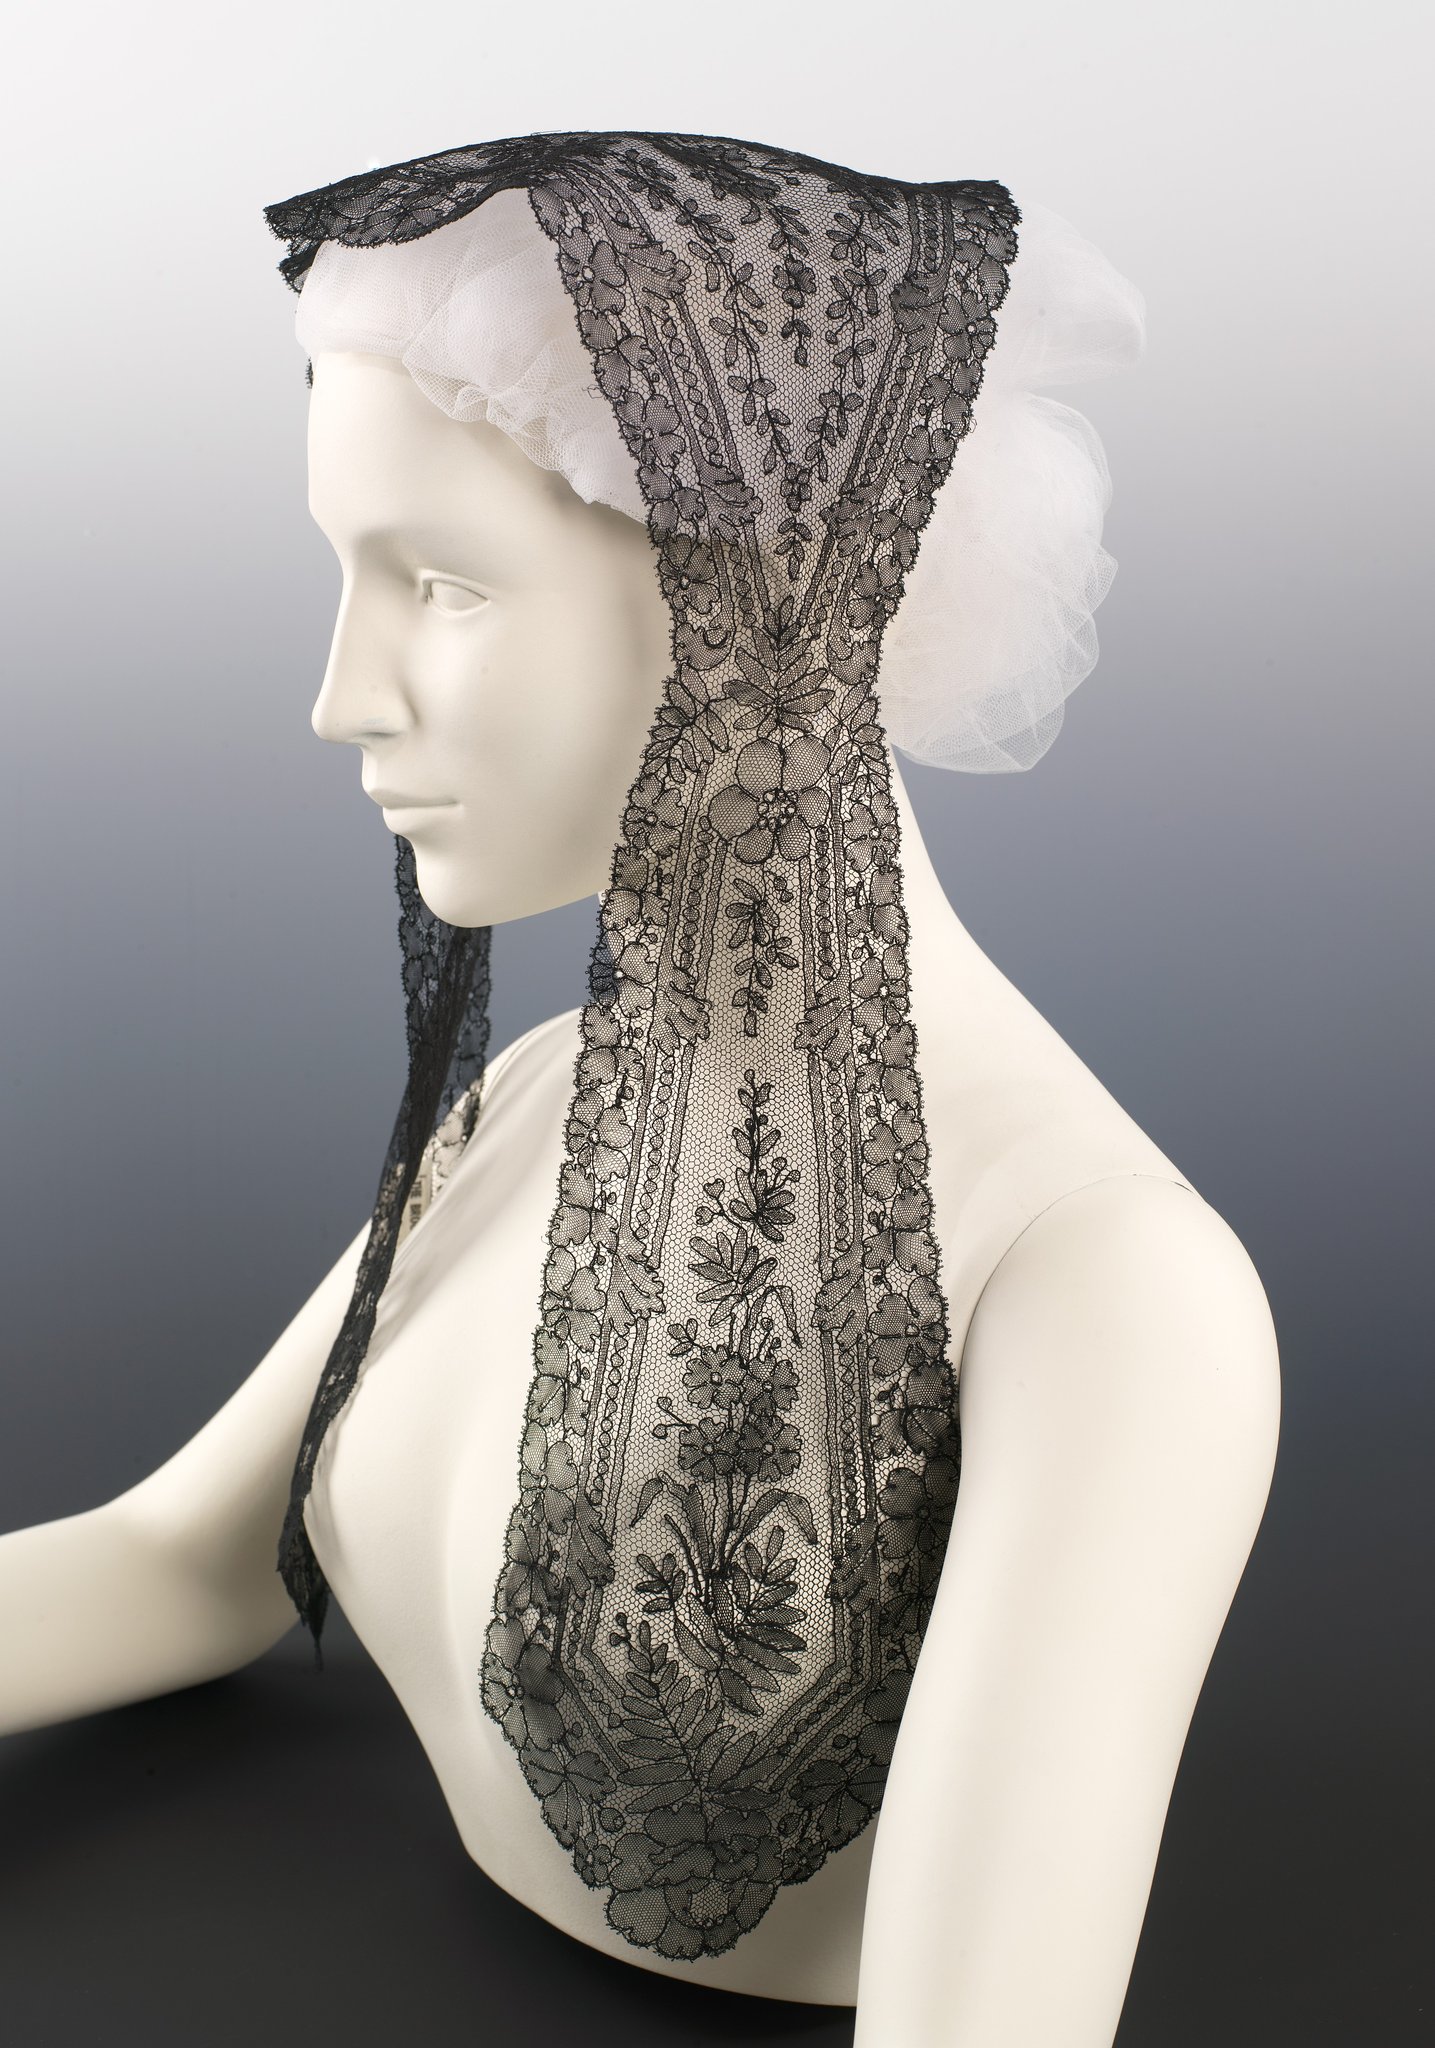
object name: fanchon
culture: french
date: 1865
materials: silk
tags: flowers